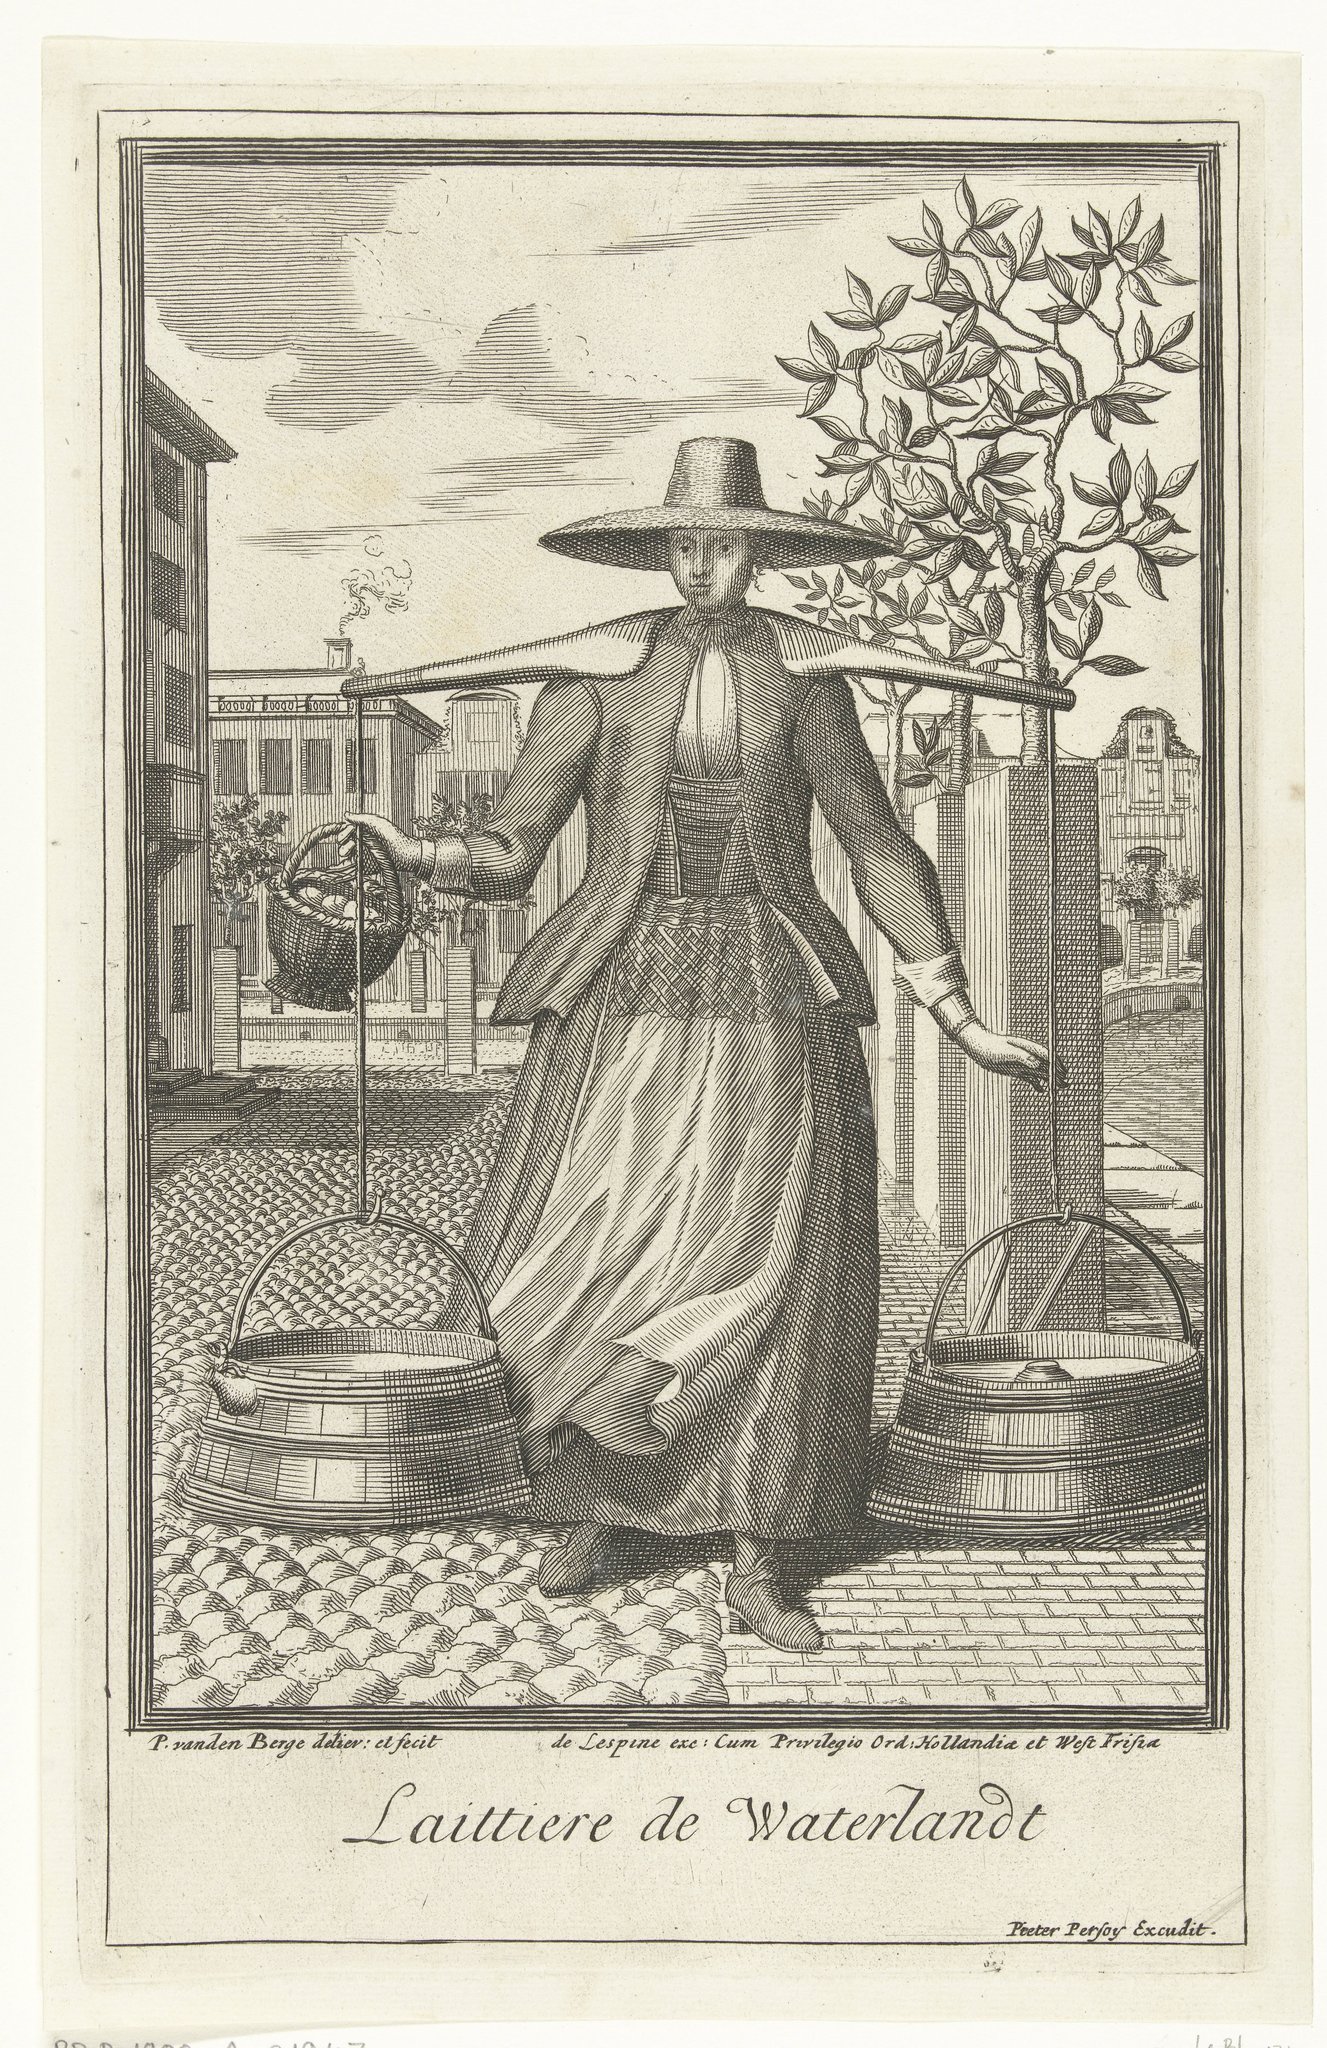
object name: print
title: Melkmeid uit Waterland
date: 1669-1689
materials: paper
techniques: engraving, etching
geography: amsterdam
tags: folk costume, regional costume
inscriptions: collector's mark: Lugt 2228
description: Een melkmeisje uit Waterland draagt een juk met twee emmers melk. In haar hand houdt zij een mand met eieren. Prent uit een serie van 10 prenten met dorpelingen die klederdrachten dragen.